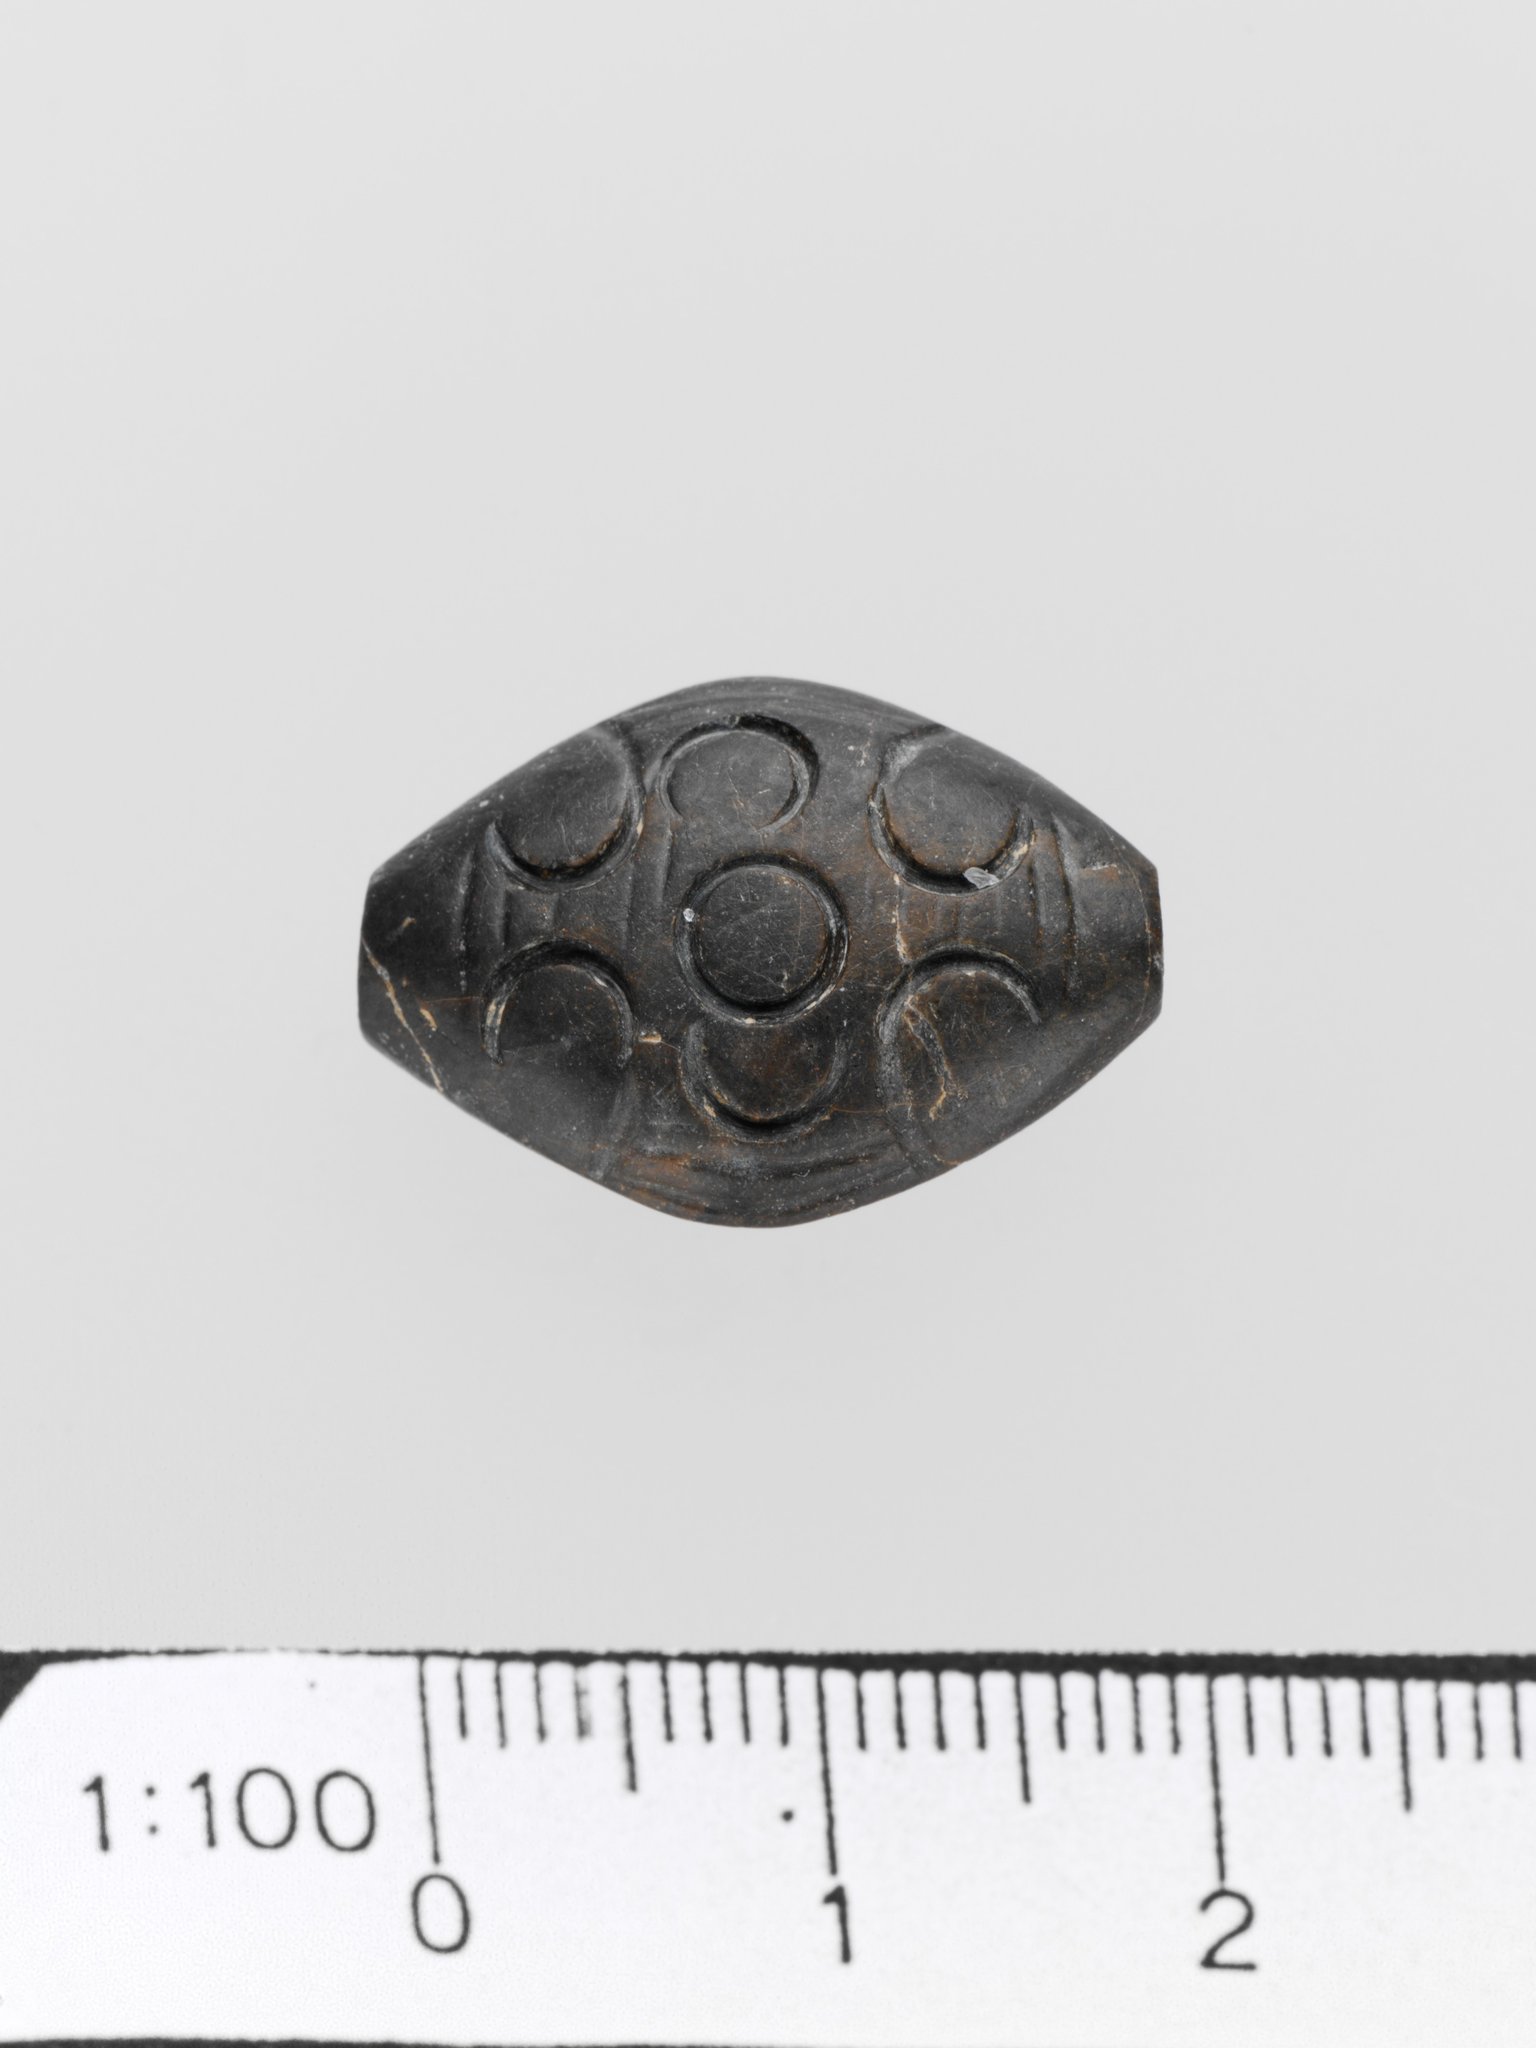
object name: seal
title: Jasper amygdaloid seal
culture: minoan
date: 1600-1450 BCE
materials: jasper